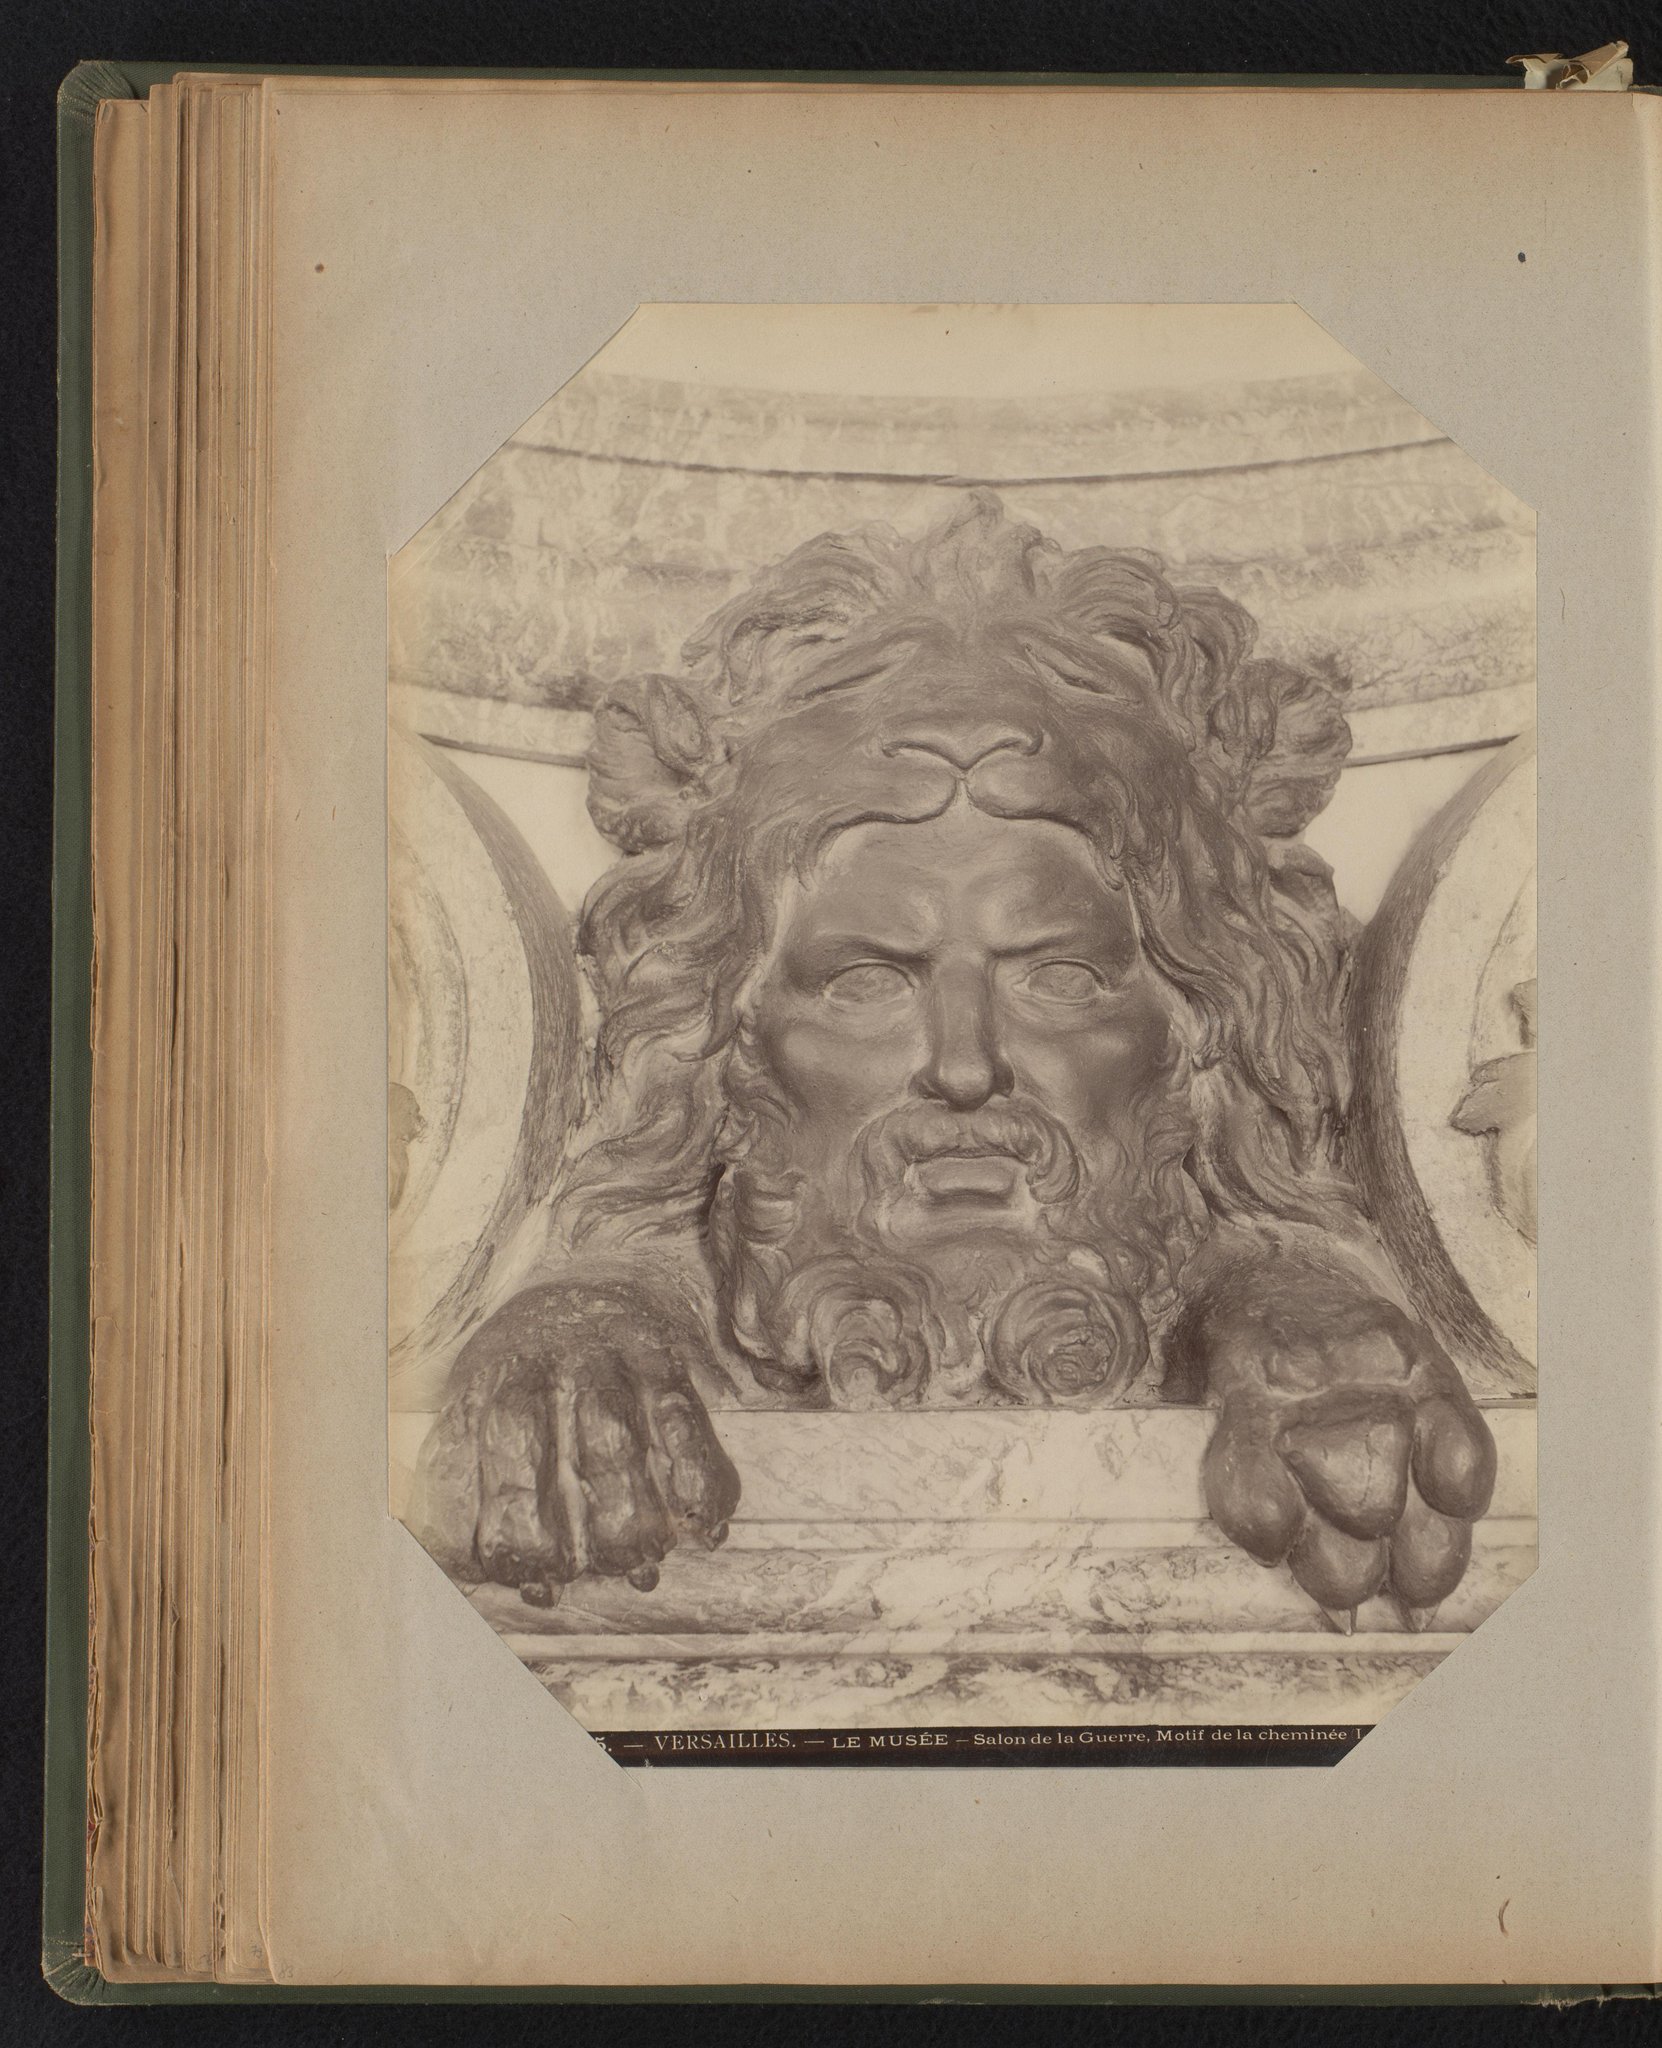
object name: photograph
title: Hoofd van Hercules met leeuwenvacht in brons boven een marmeren schouw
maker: Anonymous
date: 1860-1900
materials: paper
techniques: albumen print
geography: france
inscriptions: annotation: ‘495. - Versailles - Le Musee - Salon de Guerre, motif de la cheminee (L.P. Phot).’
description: Onderdeel van een serie met betrekking tot het interieur van het paleis van Versailles met kroonluchters, deuren, portalen en meubelstukken.